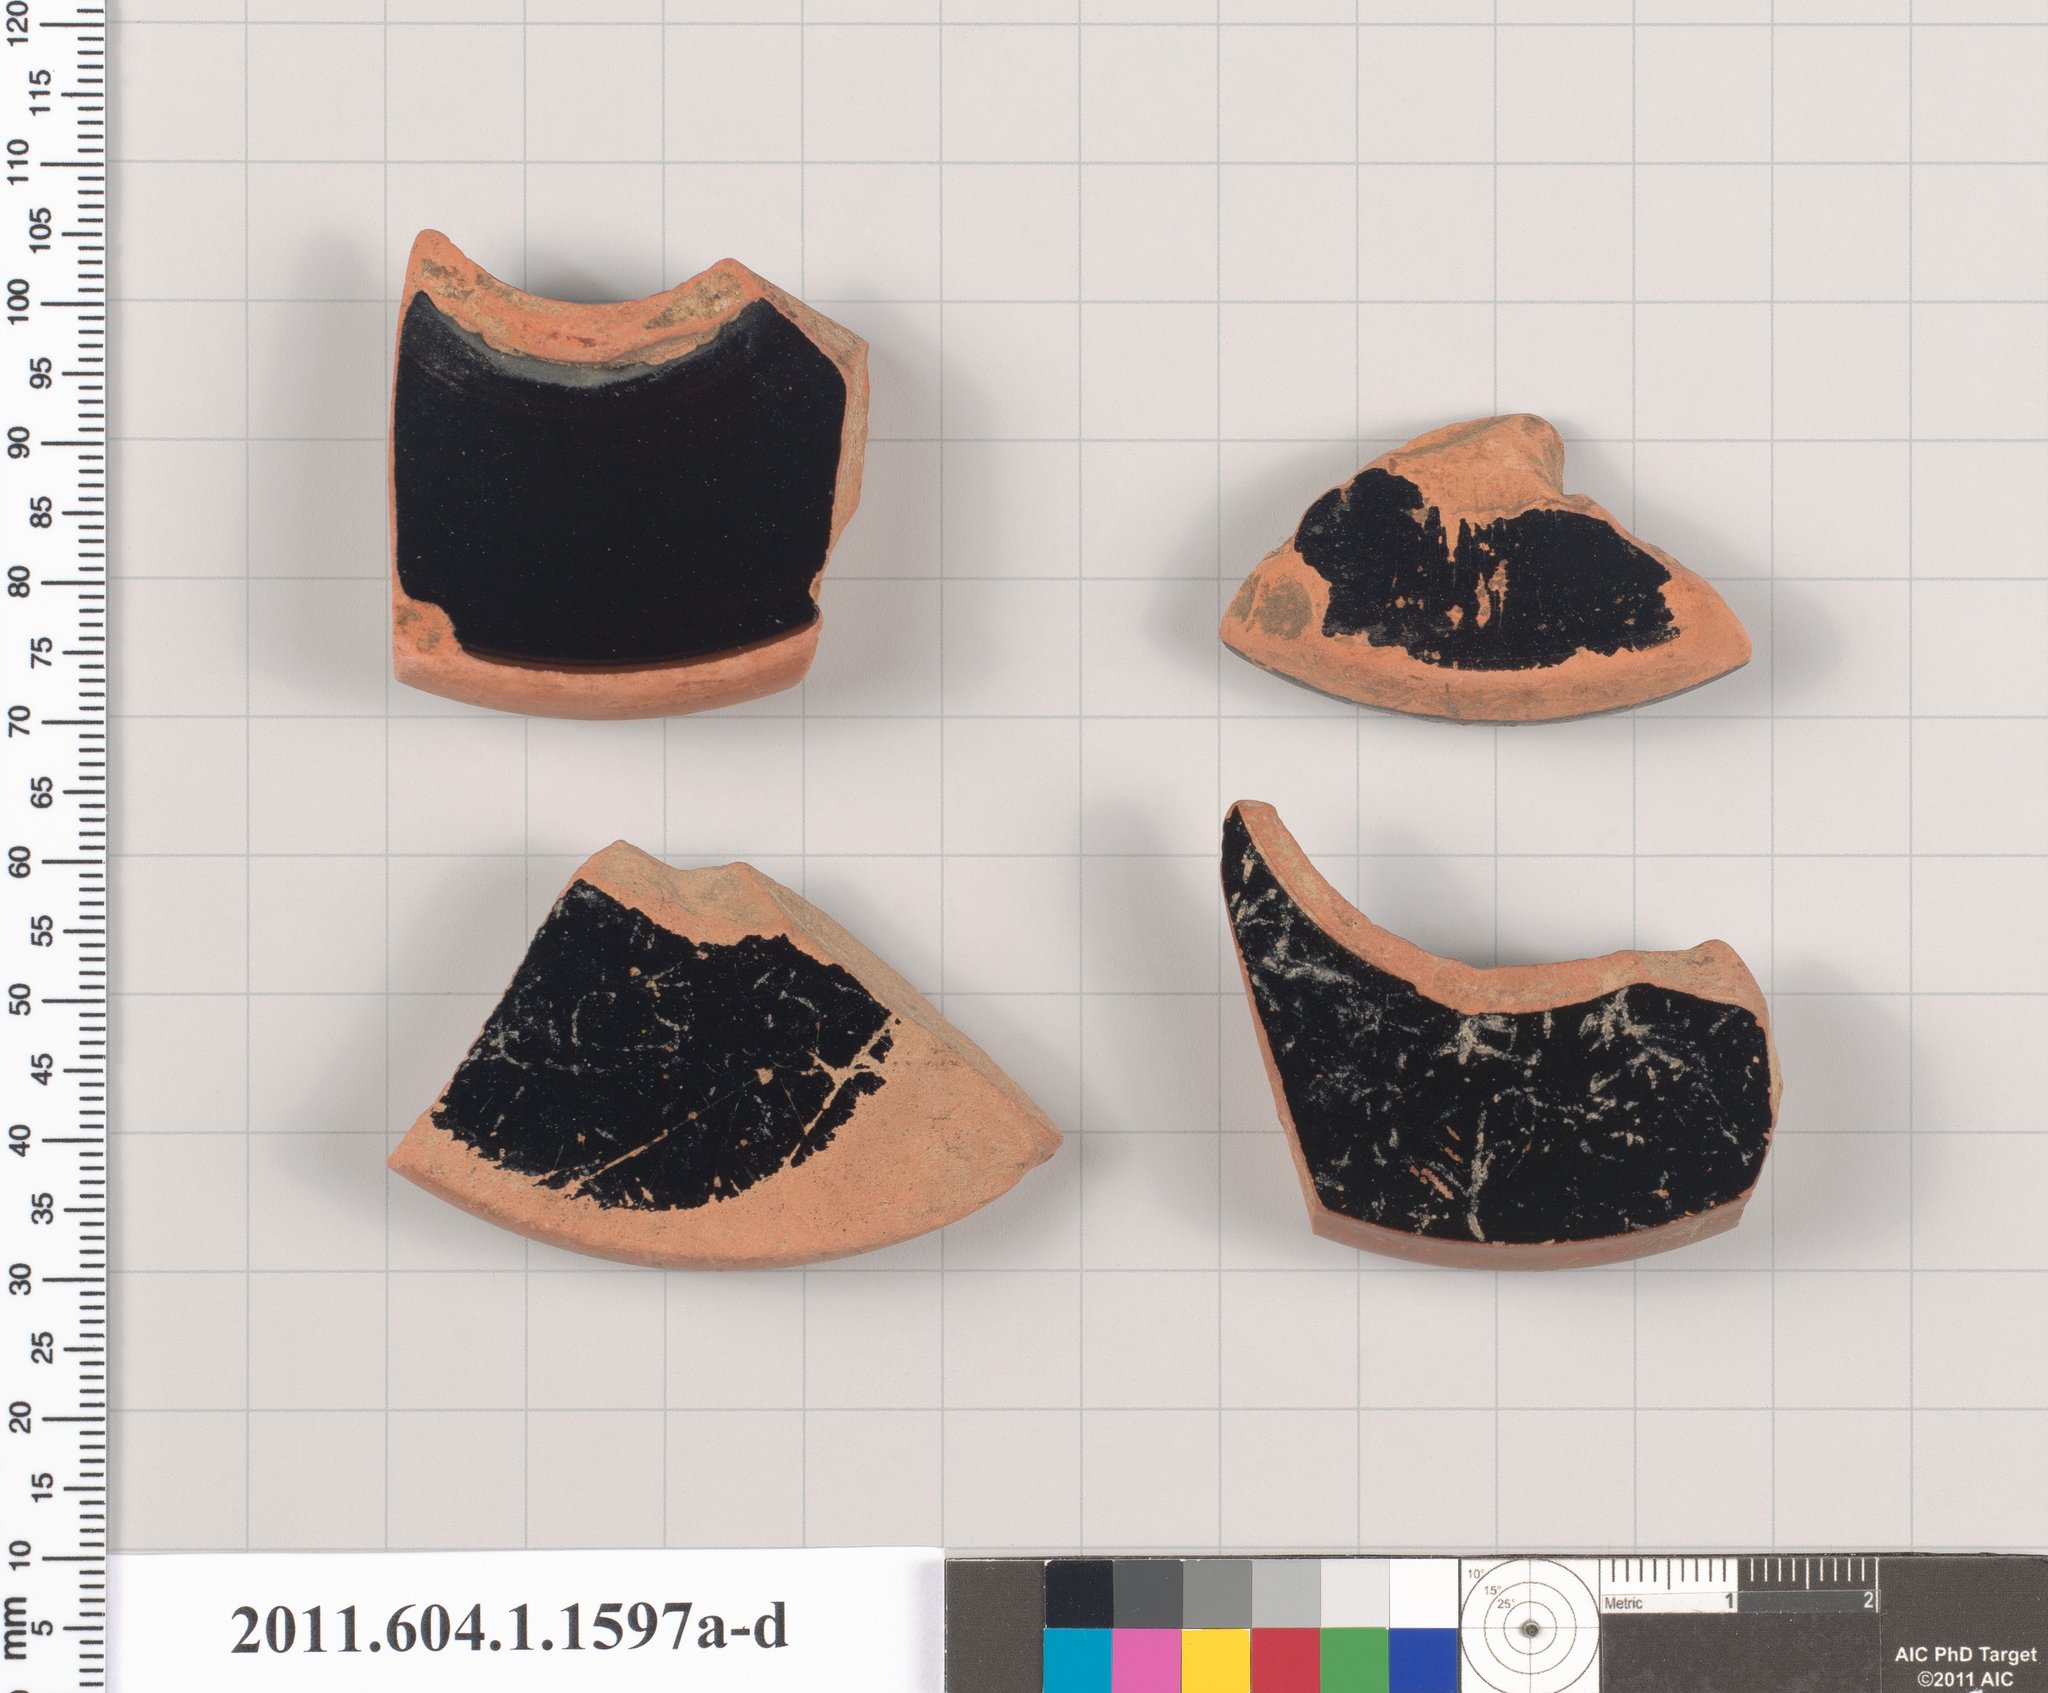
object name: kylix fragment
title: Terracotta fragments of kylikes (drinking cups)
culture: greek, attic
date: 500-401 BCE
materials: terracotta